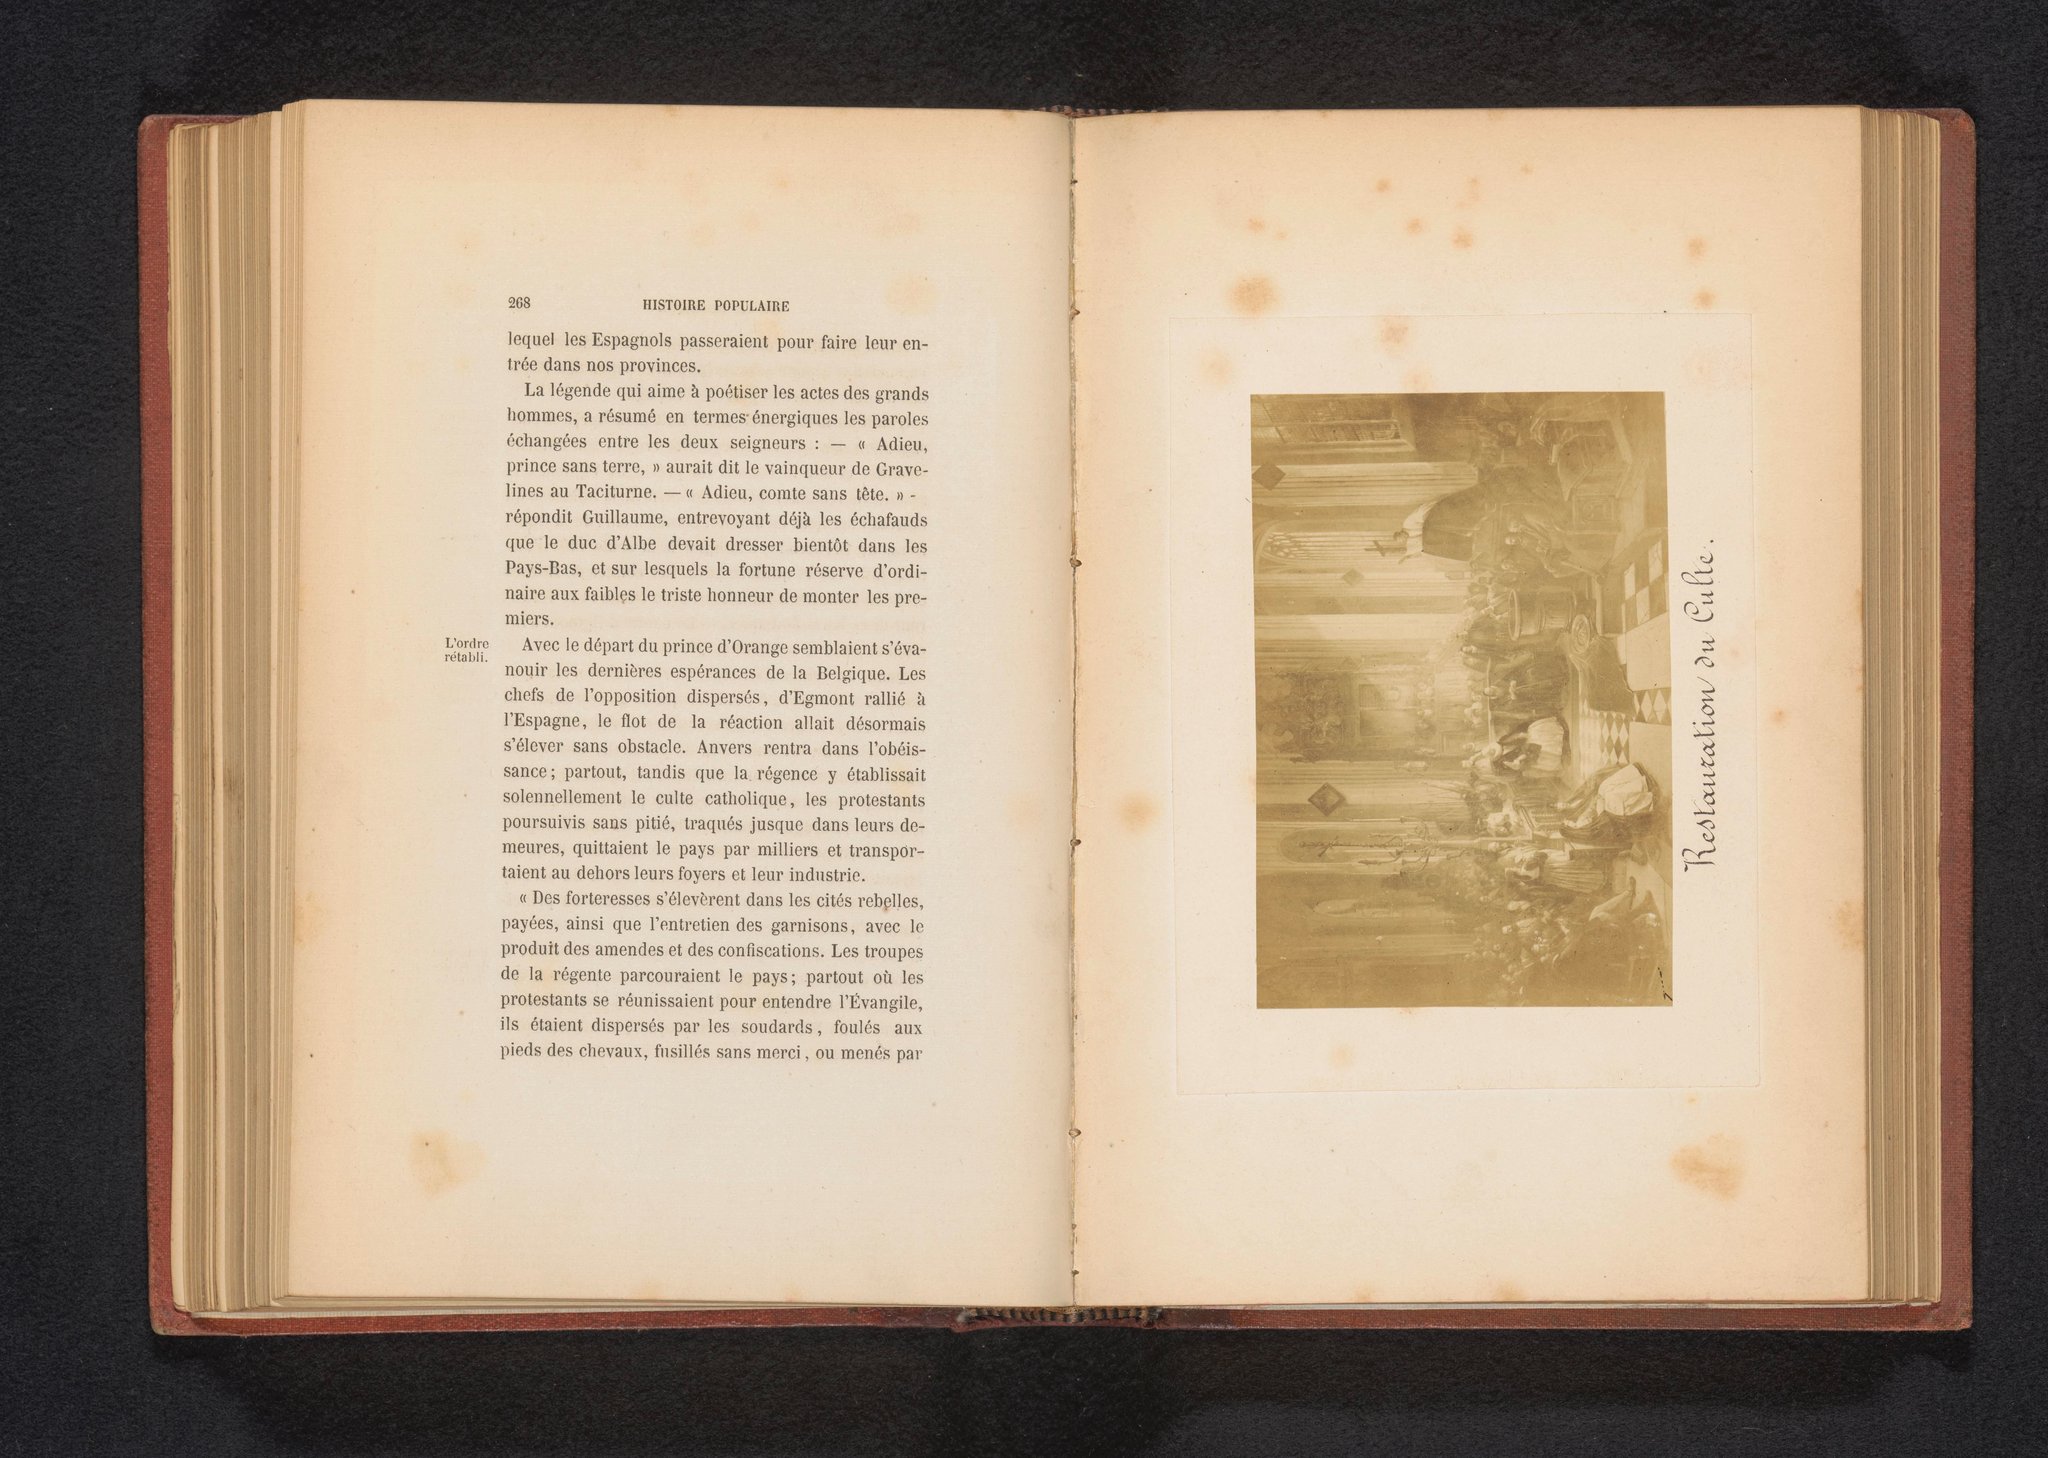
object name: page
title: Fotoreproductie van De wederinstelling van de eredienst in de Onze-Lieve-Vrouwkerk te Antwerpen door baron Henri Leys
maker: joseph maes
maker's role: fotograaf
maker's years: 1838-1908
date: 1855-1860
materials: photographic support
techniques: albumen print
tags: interior of church